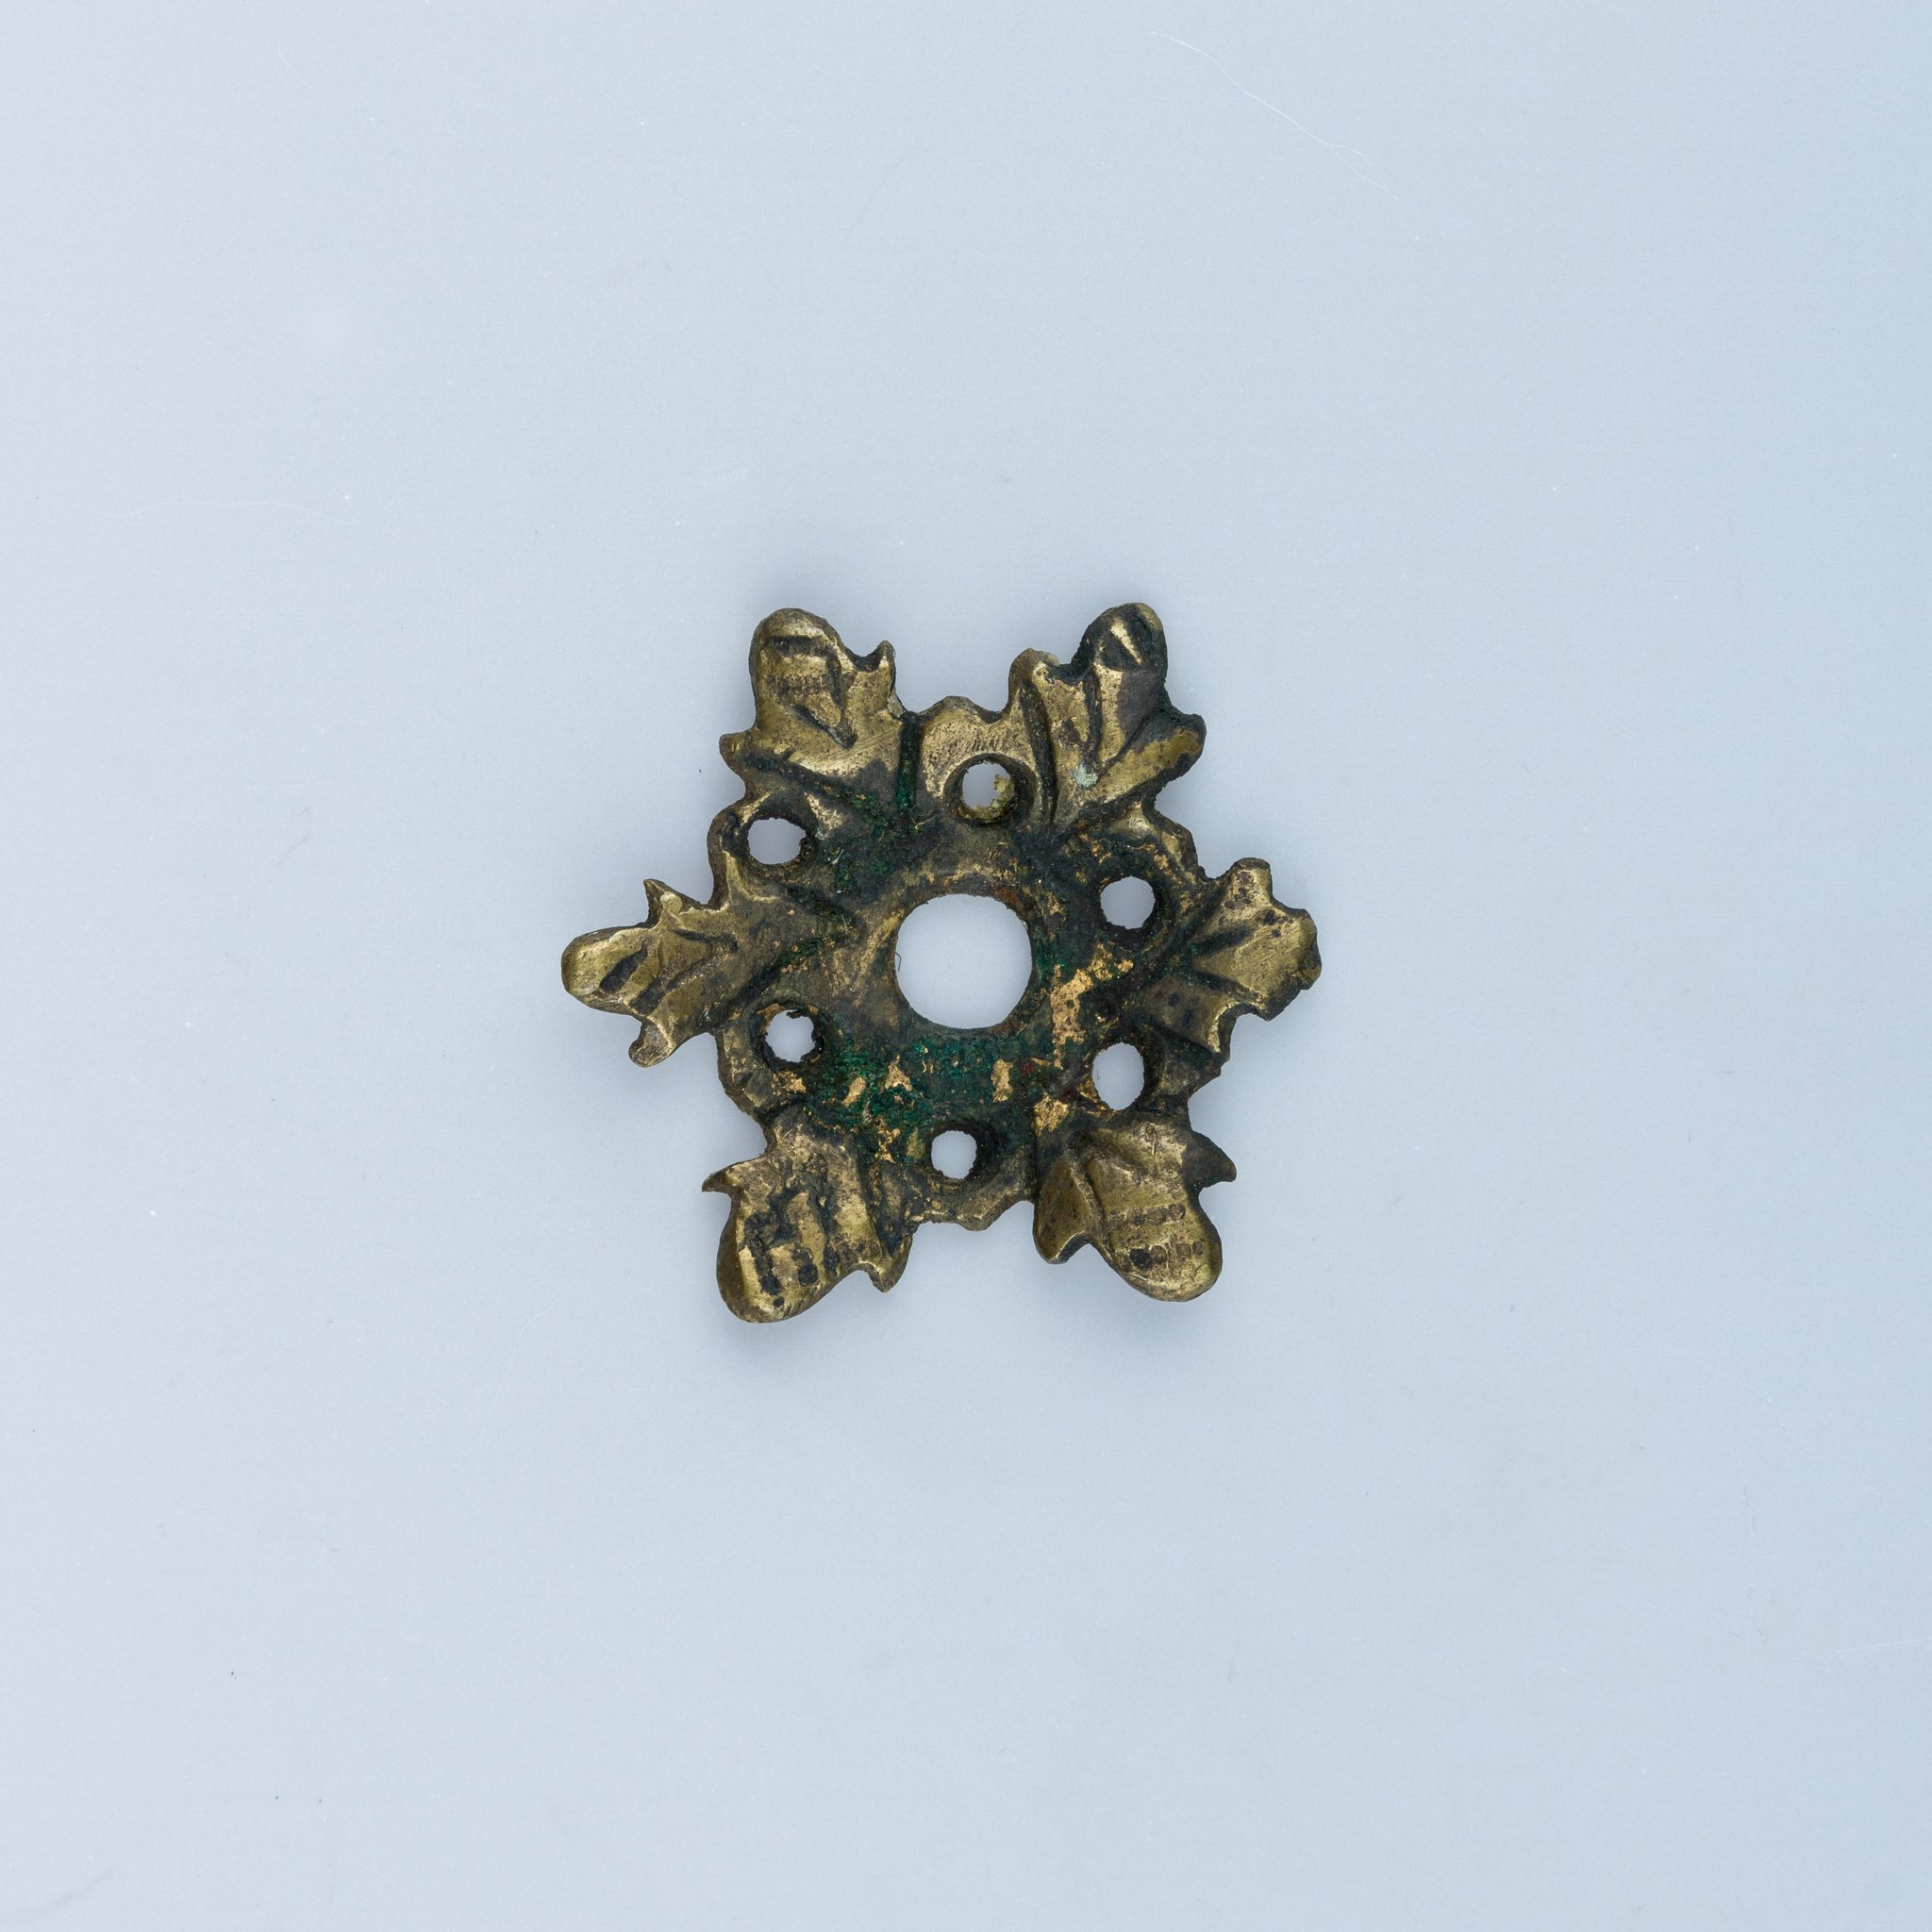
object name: rosette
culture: german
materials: brass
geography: germany